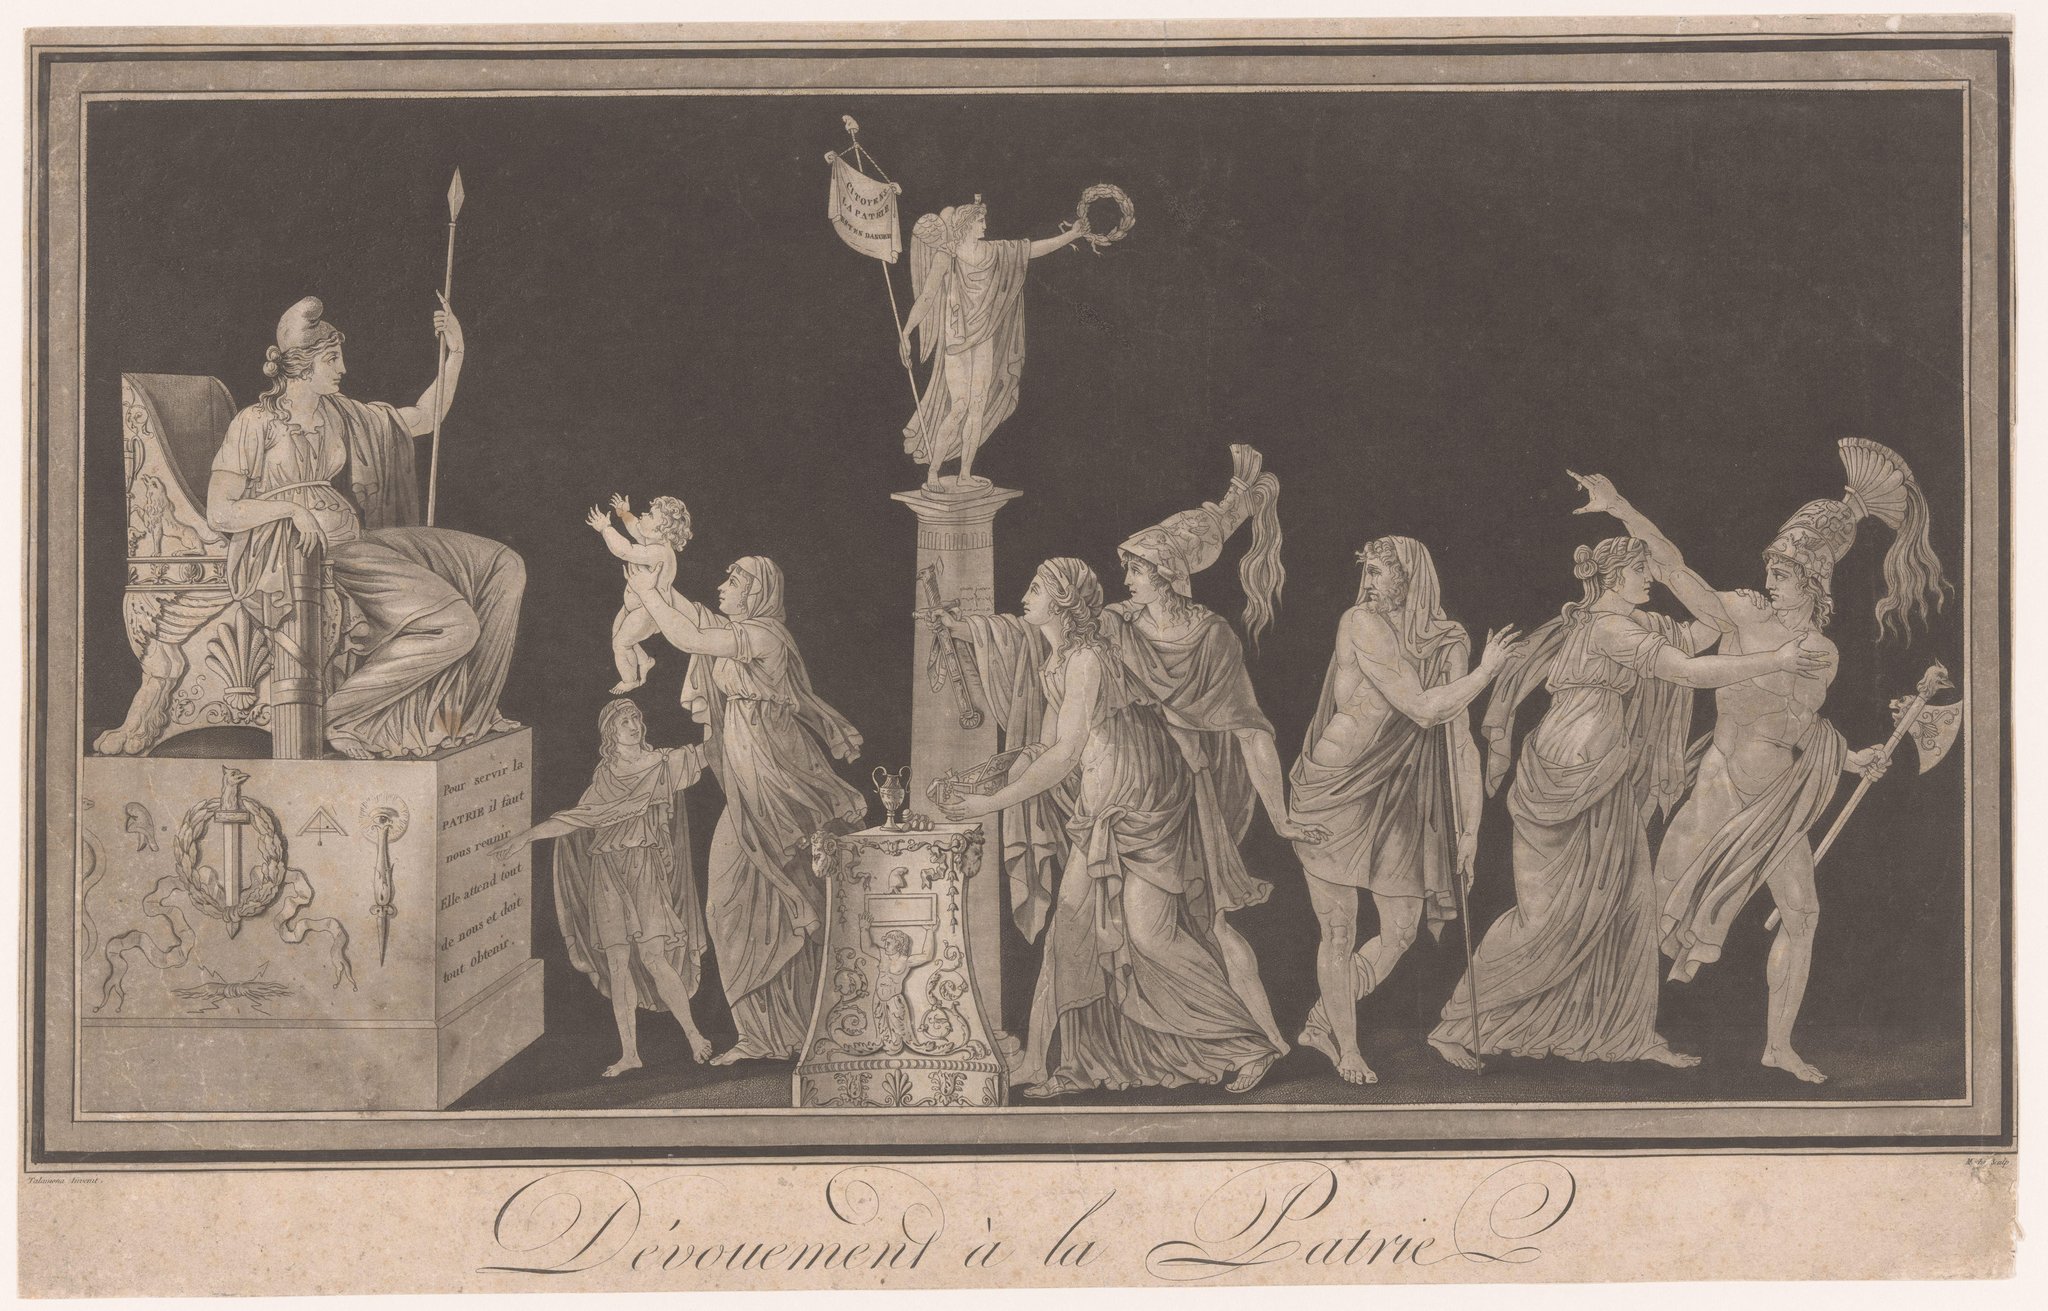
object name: print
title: Allegorie op de toewijding aan Frankrijk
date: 1733-1807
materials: paper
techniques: aquatint, etching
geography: france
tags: worship and devotion ~ non-christian religions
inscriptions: collector's mark: Lugt 2228